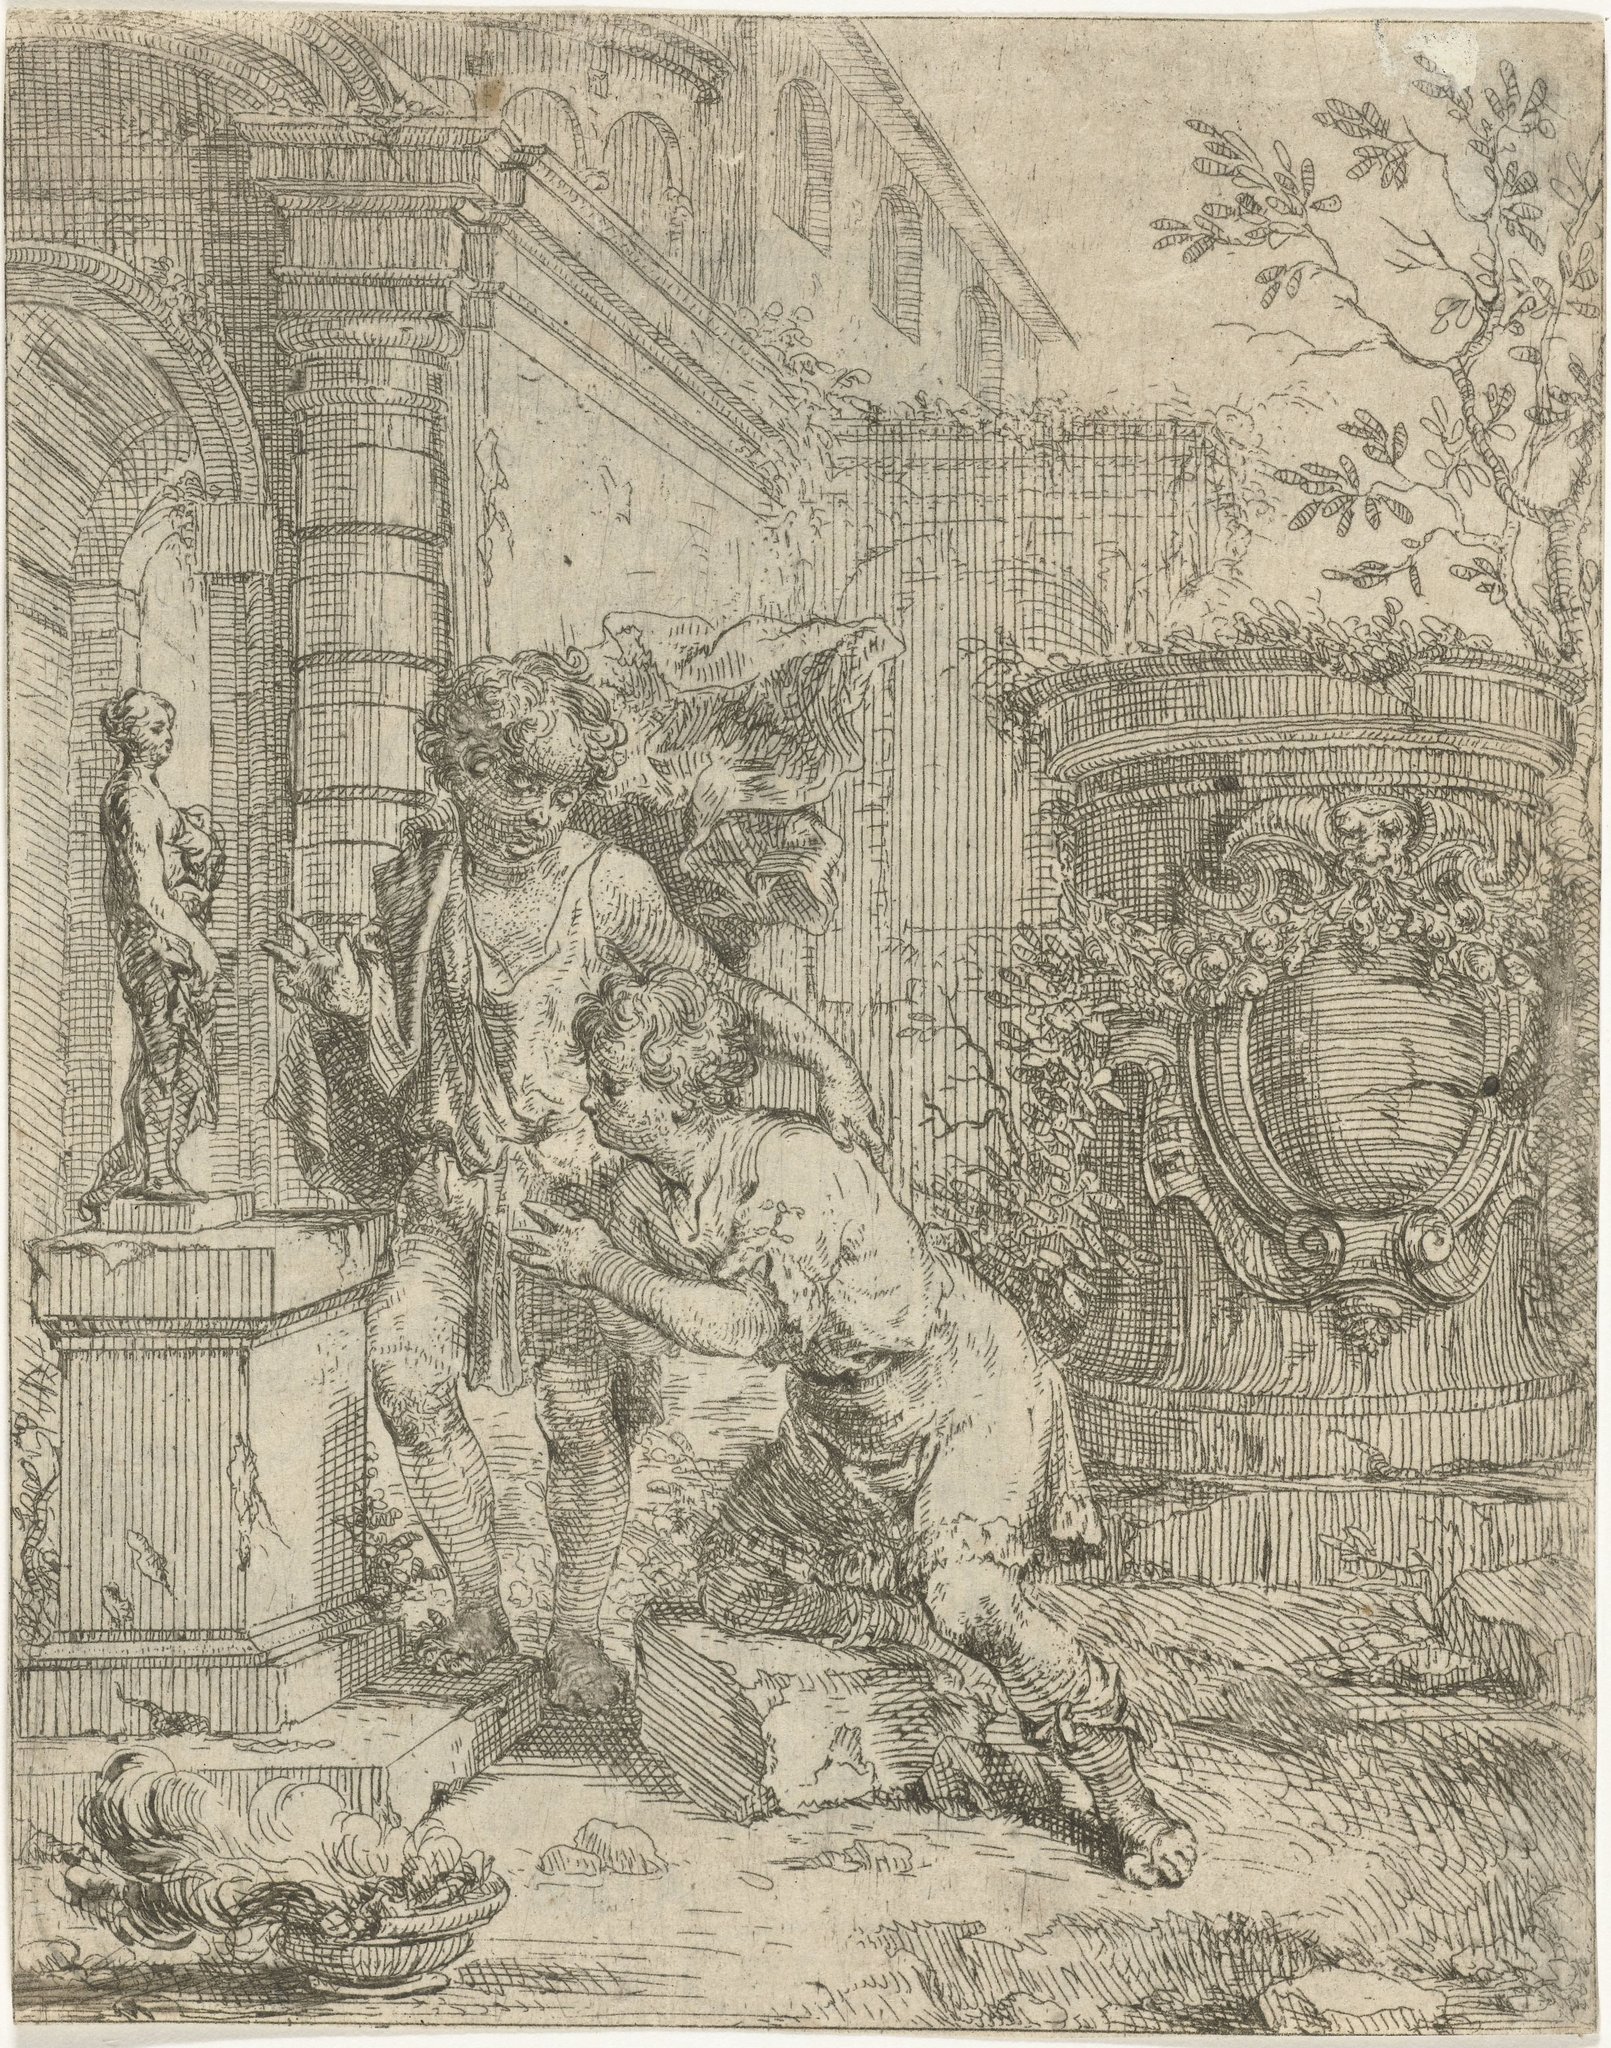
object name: print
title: Twee jongens bij beeldje van Venus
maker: louis de deyster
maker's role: draughtsman, painter, print maker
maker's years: 1656-1711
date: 1666-1711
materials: paper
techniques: etching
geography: southern netherlands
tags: veneration of venus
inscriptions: collector's mark: Lugt 514, collector's mark: ‘F Rechberger 1803’ Lugt 2133, collector's mark: Lugt 2228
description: Twee jongens bij beeldje van Venus, met brandende offerschaal in tuin. Op verso fragment van plaatafdruk van Hagar getroost door de engel.